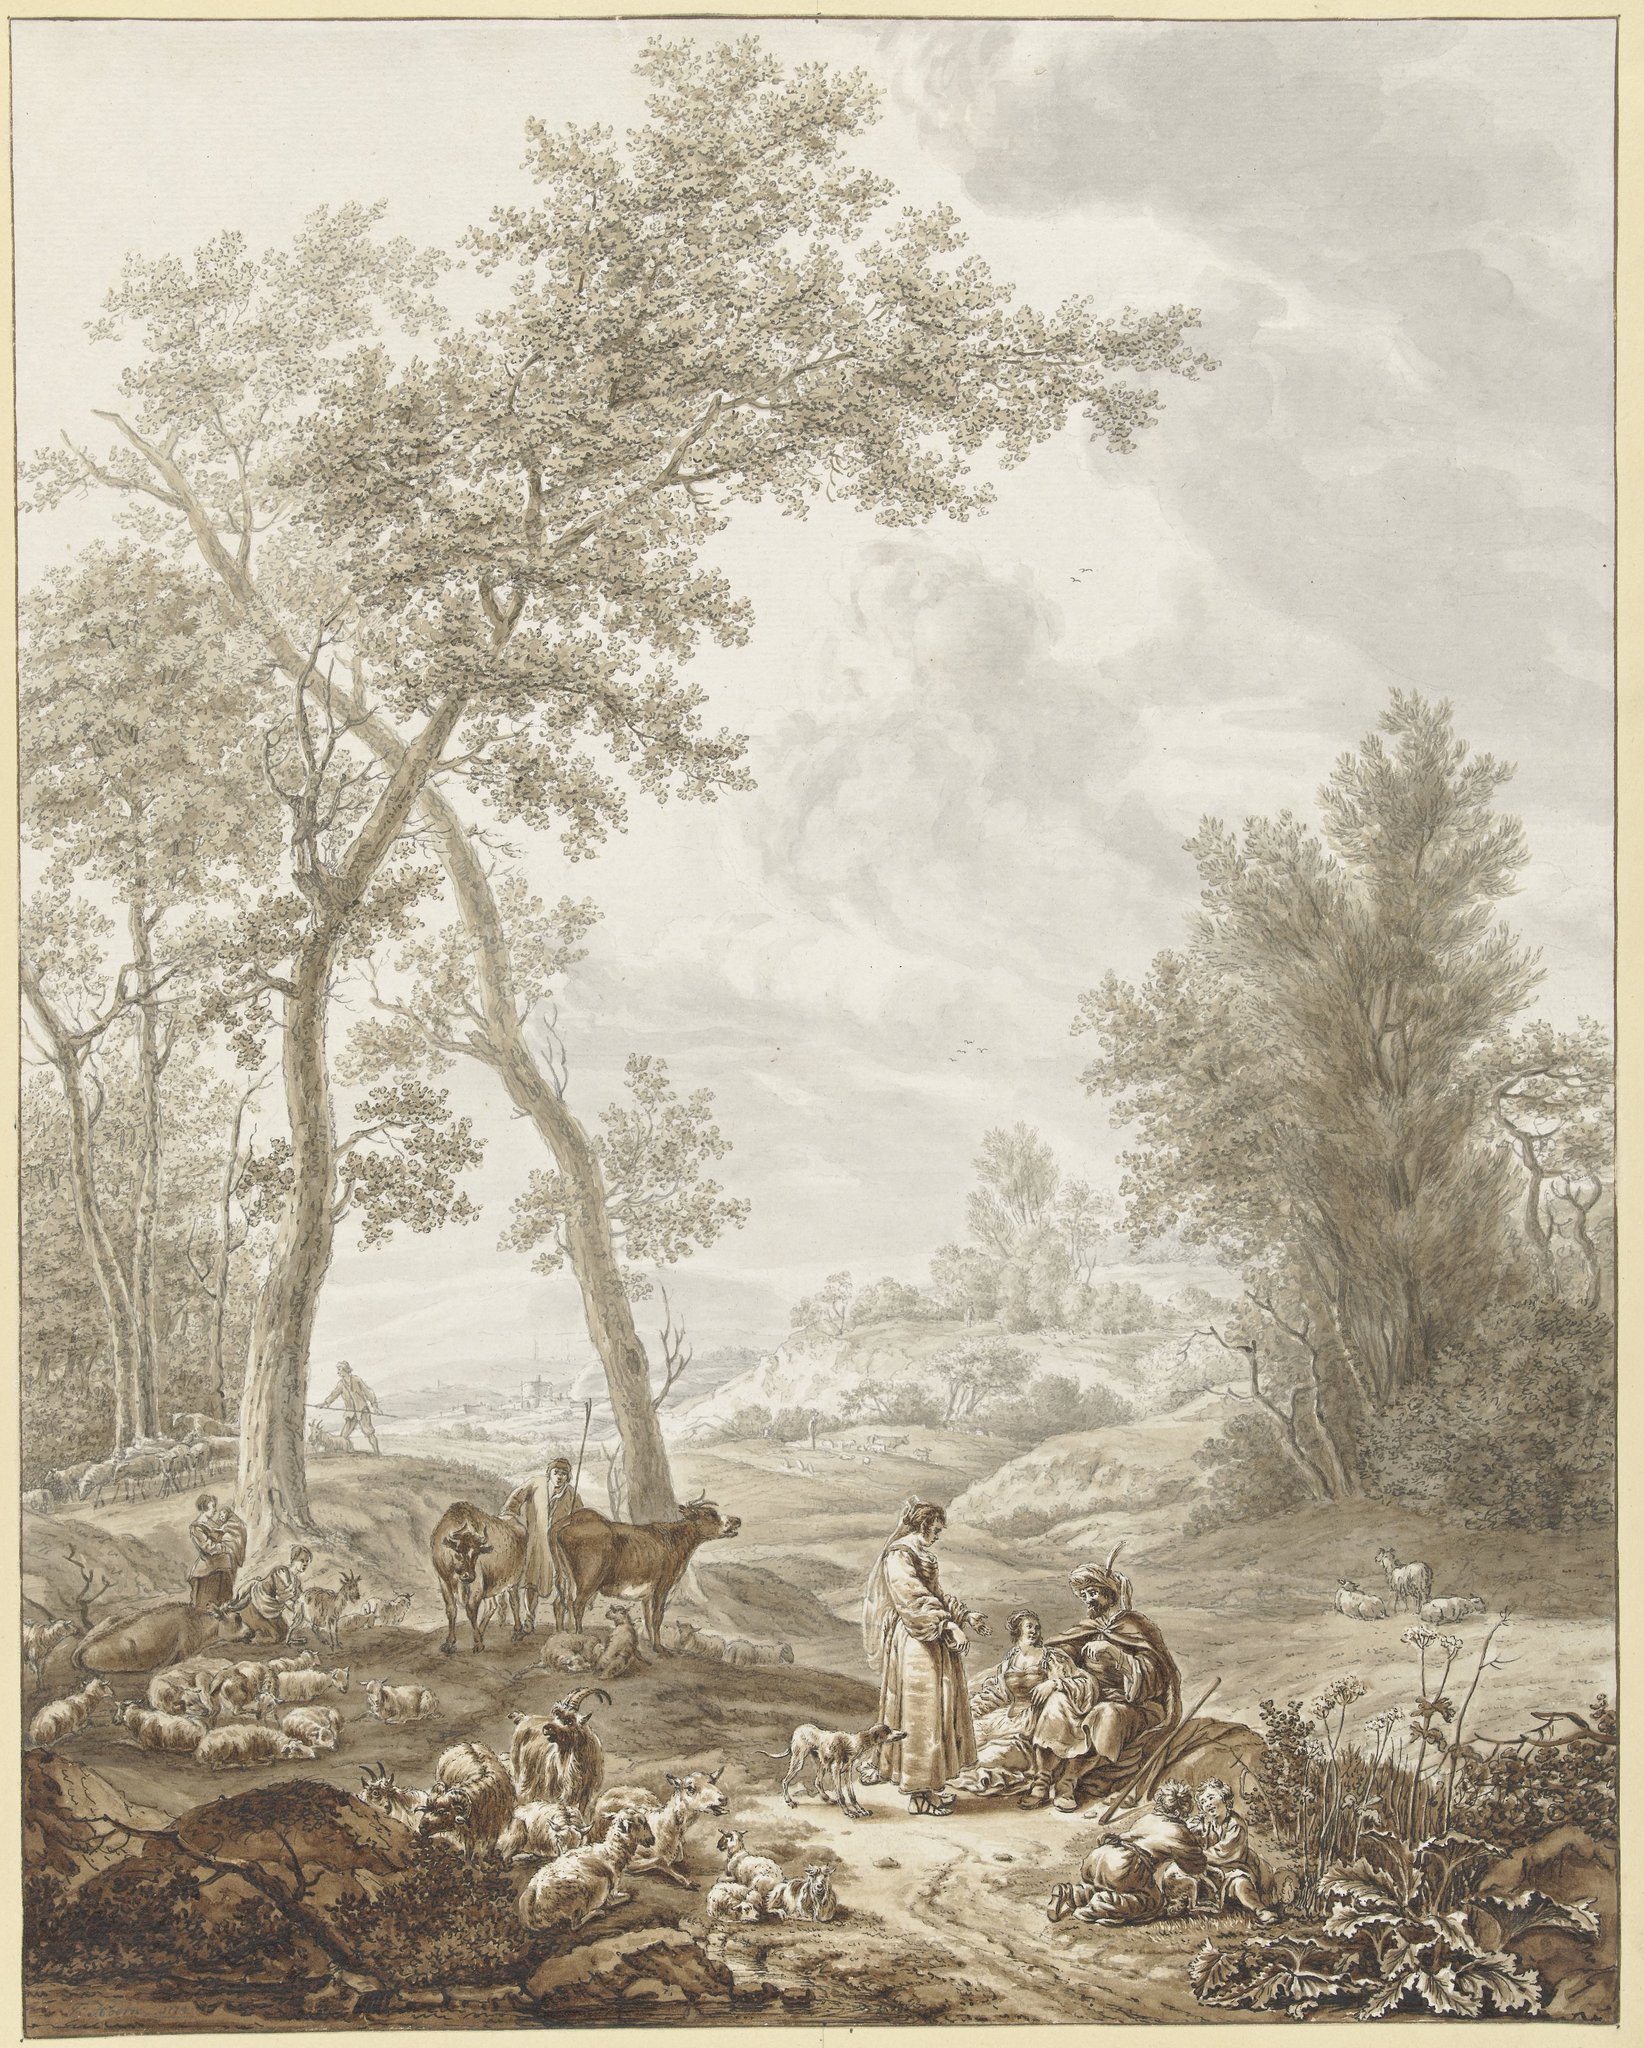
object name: drawing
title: Elkanah and His Wives Hannah and Peninnah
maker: jordanus hoorn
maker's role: draughtsman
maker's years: 1753-1833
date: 1774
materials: ink, paper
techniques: brush, pen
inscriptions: date: ‘1774’